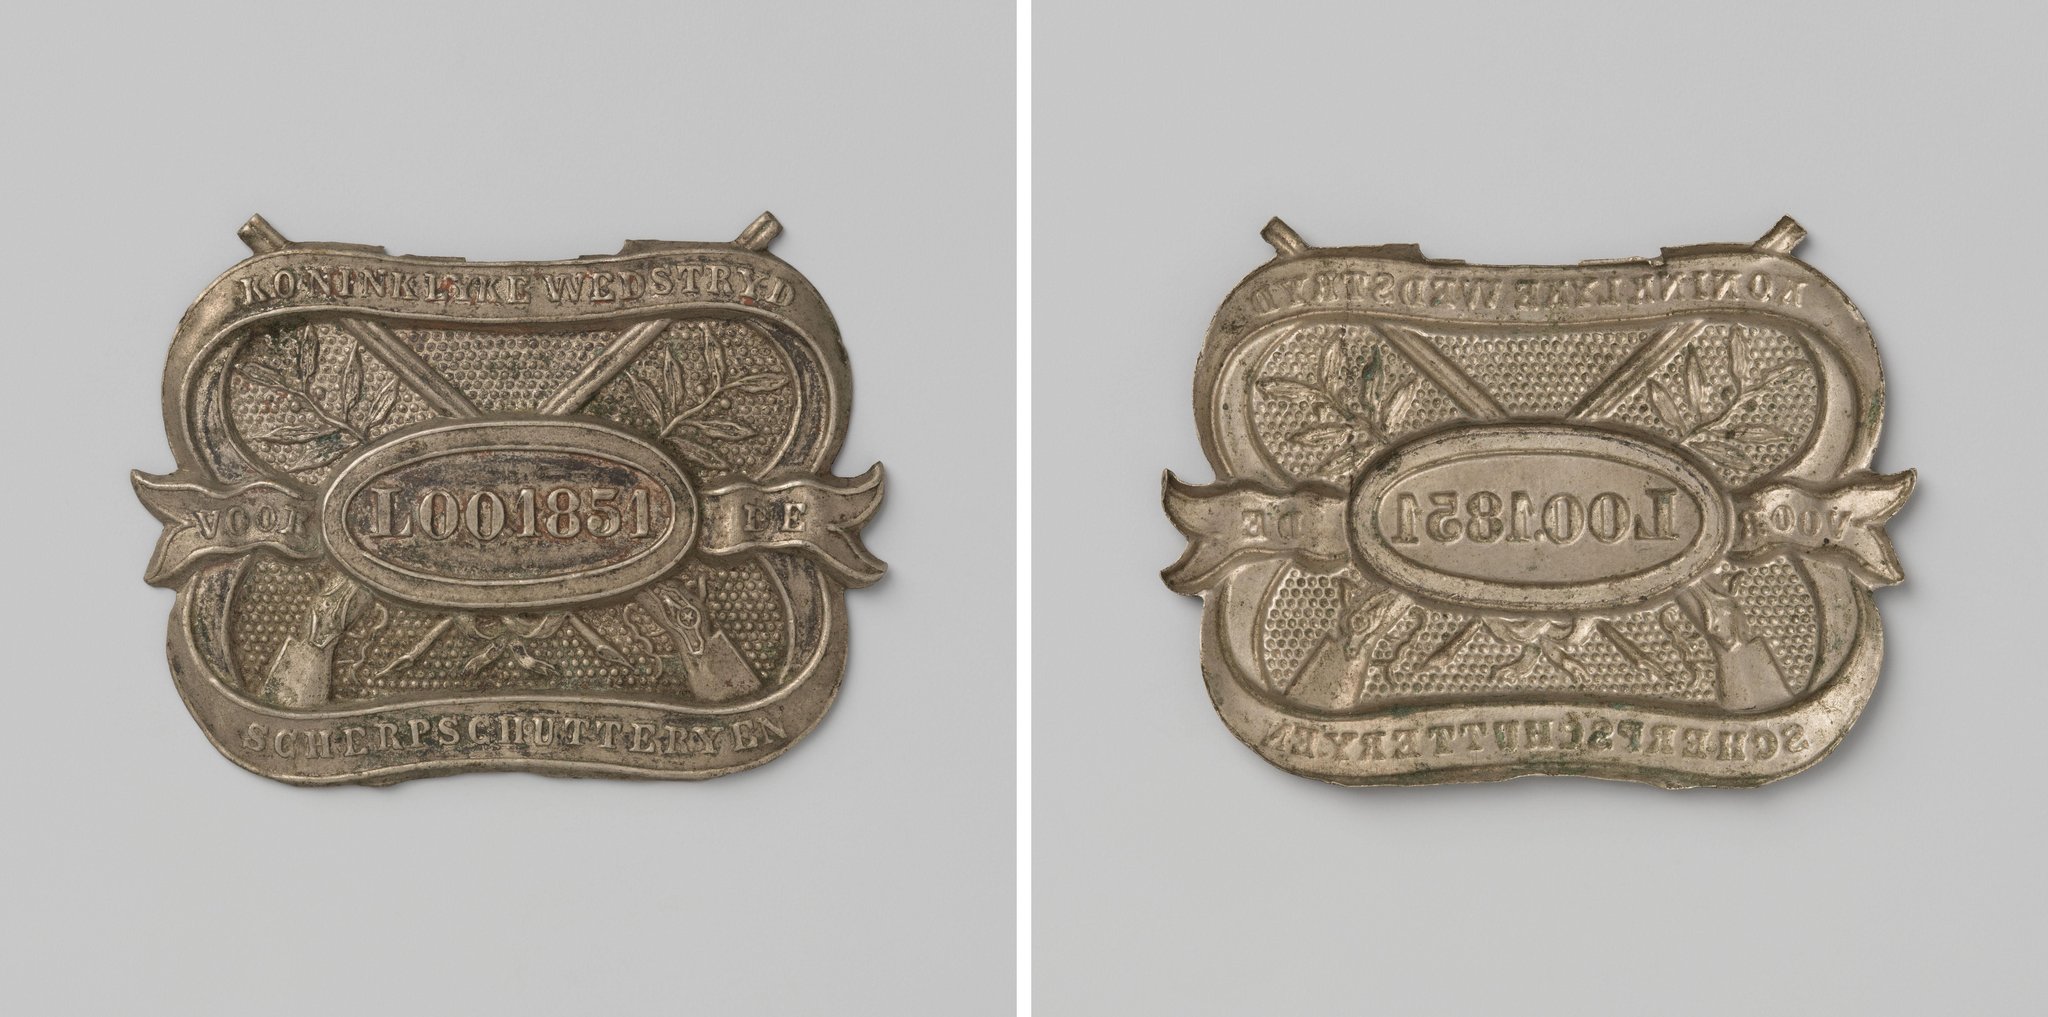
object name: marksman medal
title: Koninklijke wedstrijd voor scherpschutterijen op het Loo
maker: Anonymous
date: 1851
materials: silver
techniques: striking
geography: netherlands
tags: paleis het loo